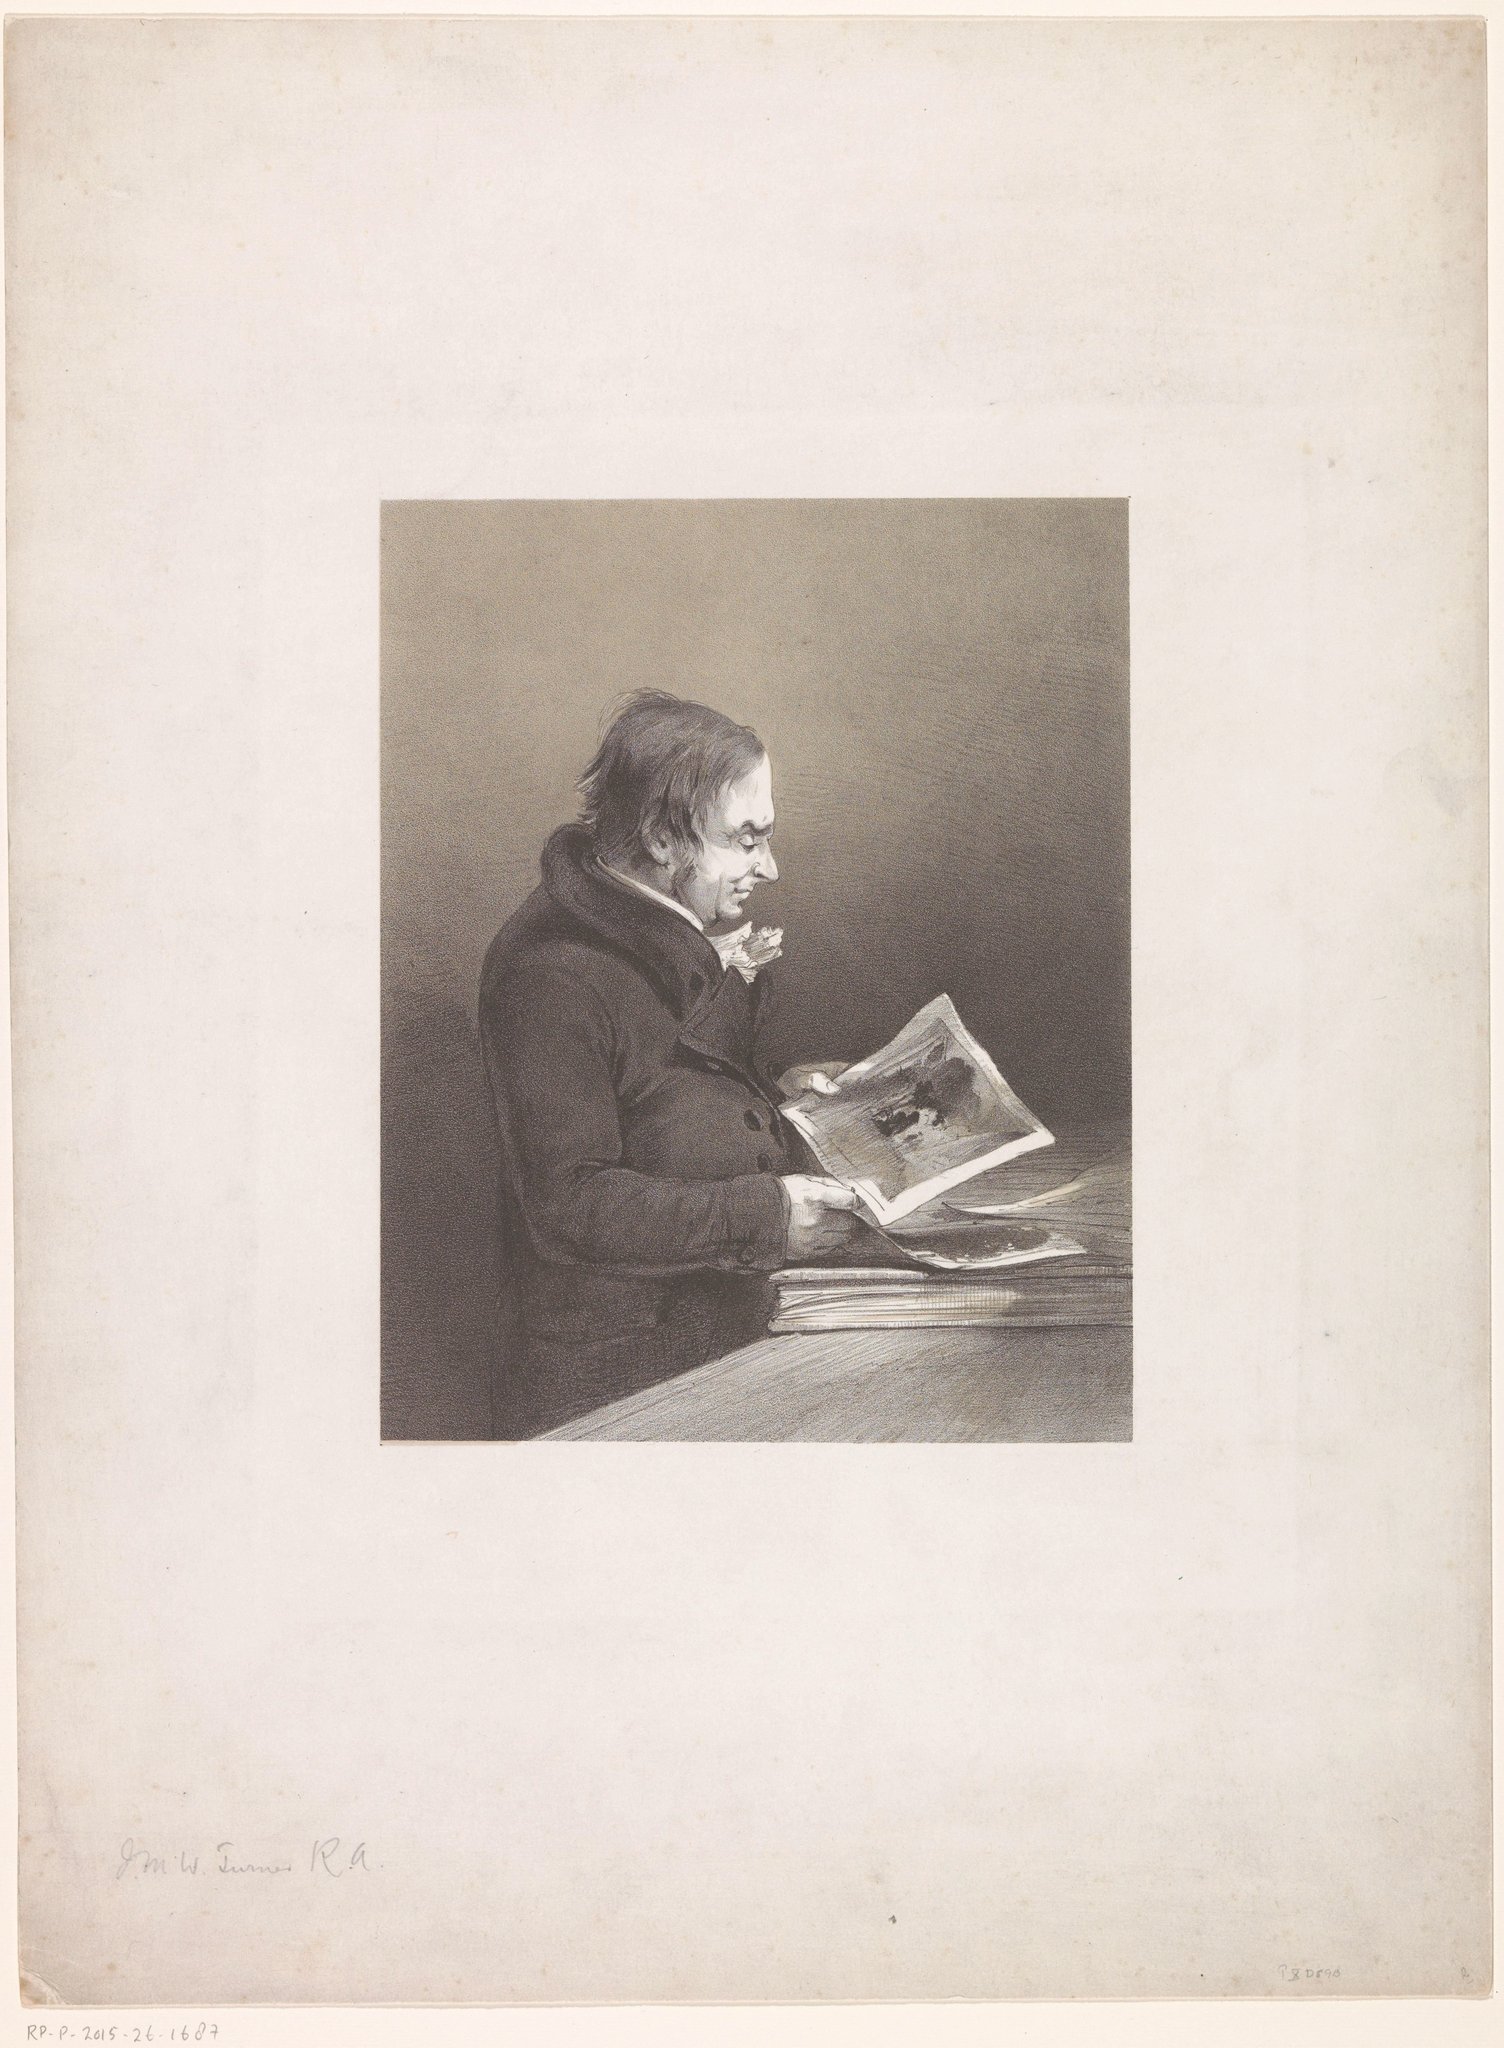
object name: print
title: Portret van kunstenaar Joseph Mallord William Turner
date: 1823-1852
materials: paper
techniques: tone lithography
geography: london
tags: london, print maker, draughtsman, joseph mallord william turner, print, e.g.: engraving, etching, lithograph, portrait, self-portrait of artist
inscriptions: annotation: ‘J.M.W. Turner / Proof before letters / Drawn in the print room of the British Museum / Published by M.M. Holloway, Covent Garden’, collector's mark: Lugt 2228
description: Portret van kunstenaar Joseph Mallord William Turner die een prent bekijkt in het prentenkabinet van het British Museum.